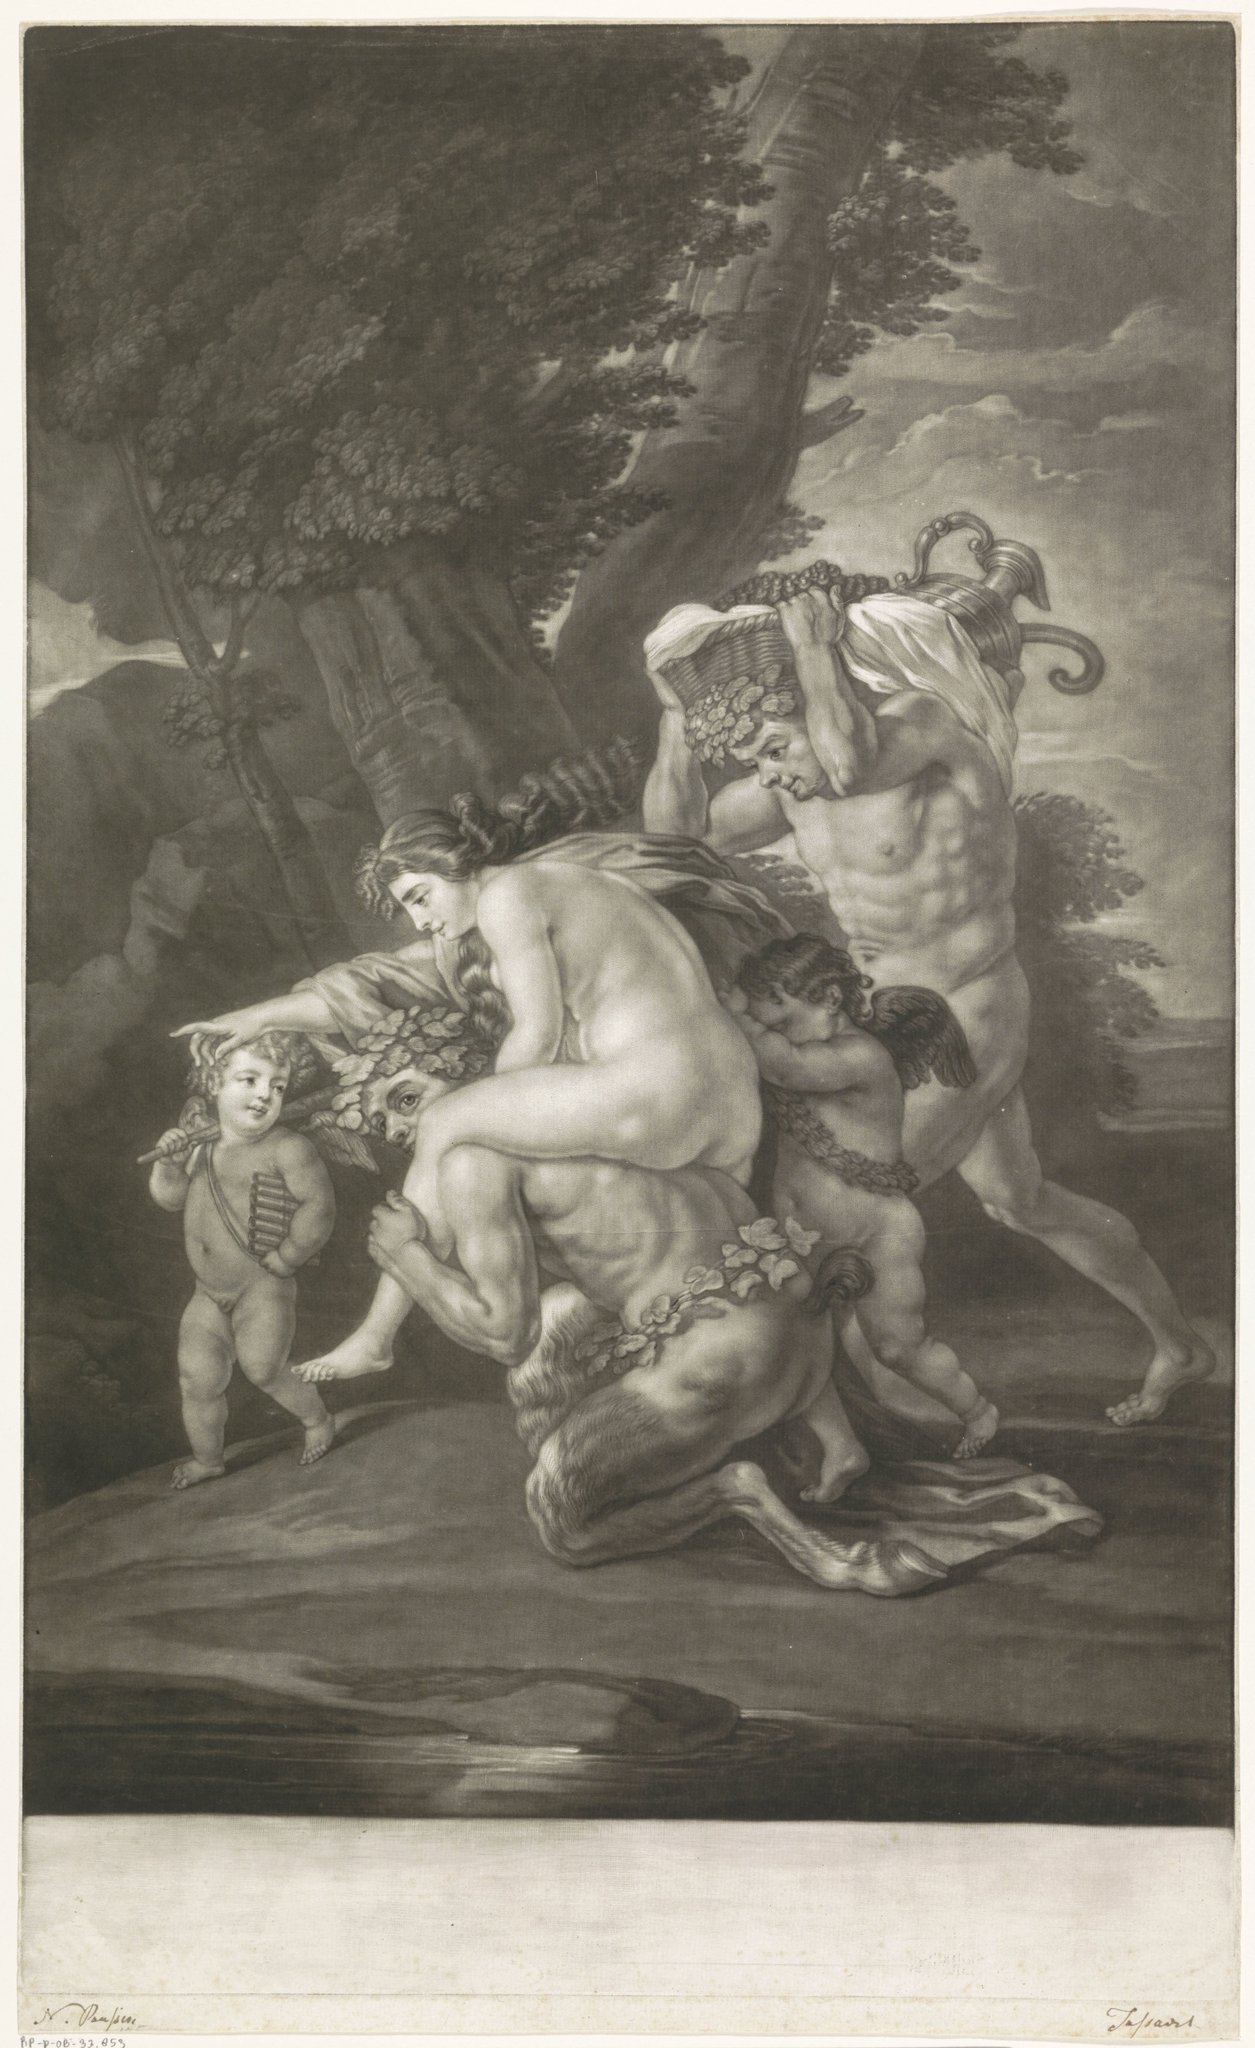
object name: print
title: Bacchanten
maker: philippe joseph tassaert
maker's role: print maker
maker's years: 1732-1803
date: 1769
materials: paper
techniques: mezzotint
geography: london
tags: maenad(s), female bacchant(es), male bacchant(es), forest, wood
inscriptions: collector's mark: Lugt 240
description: Naakte bachanten in een bos. Een jonge vrouw klimpt op de rug van een sater en wordt hierbij geholpen door een putto. Achter hen loopt een man met een mand op zijn rug die is gevuld met wijn en druiven.